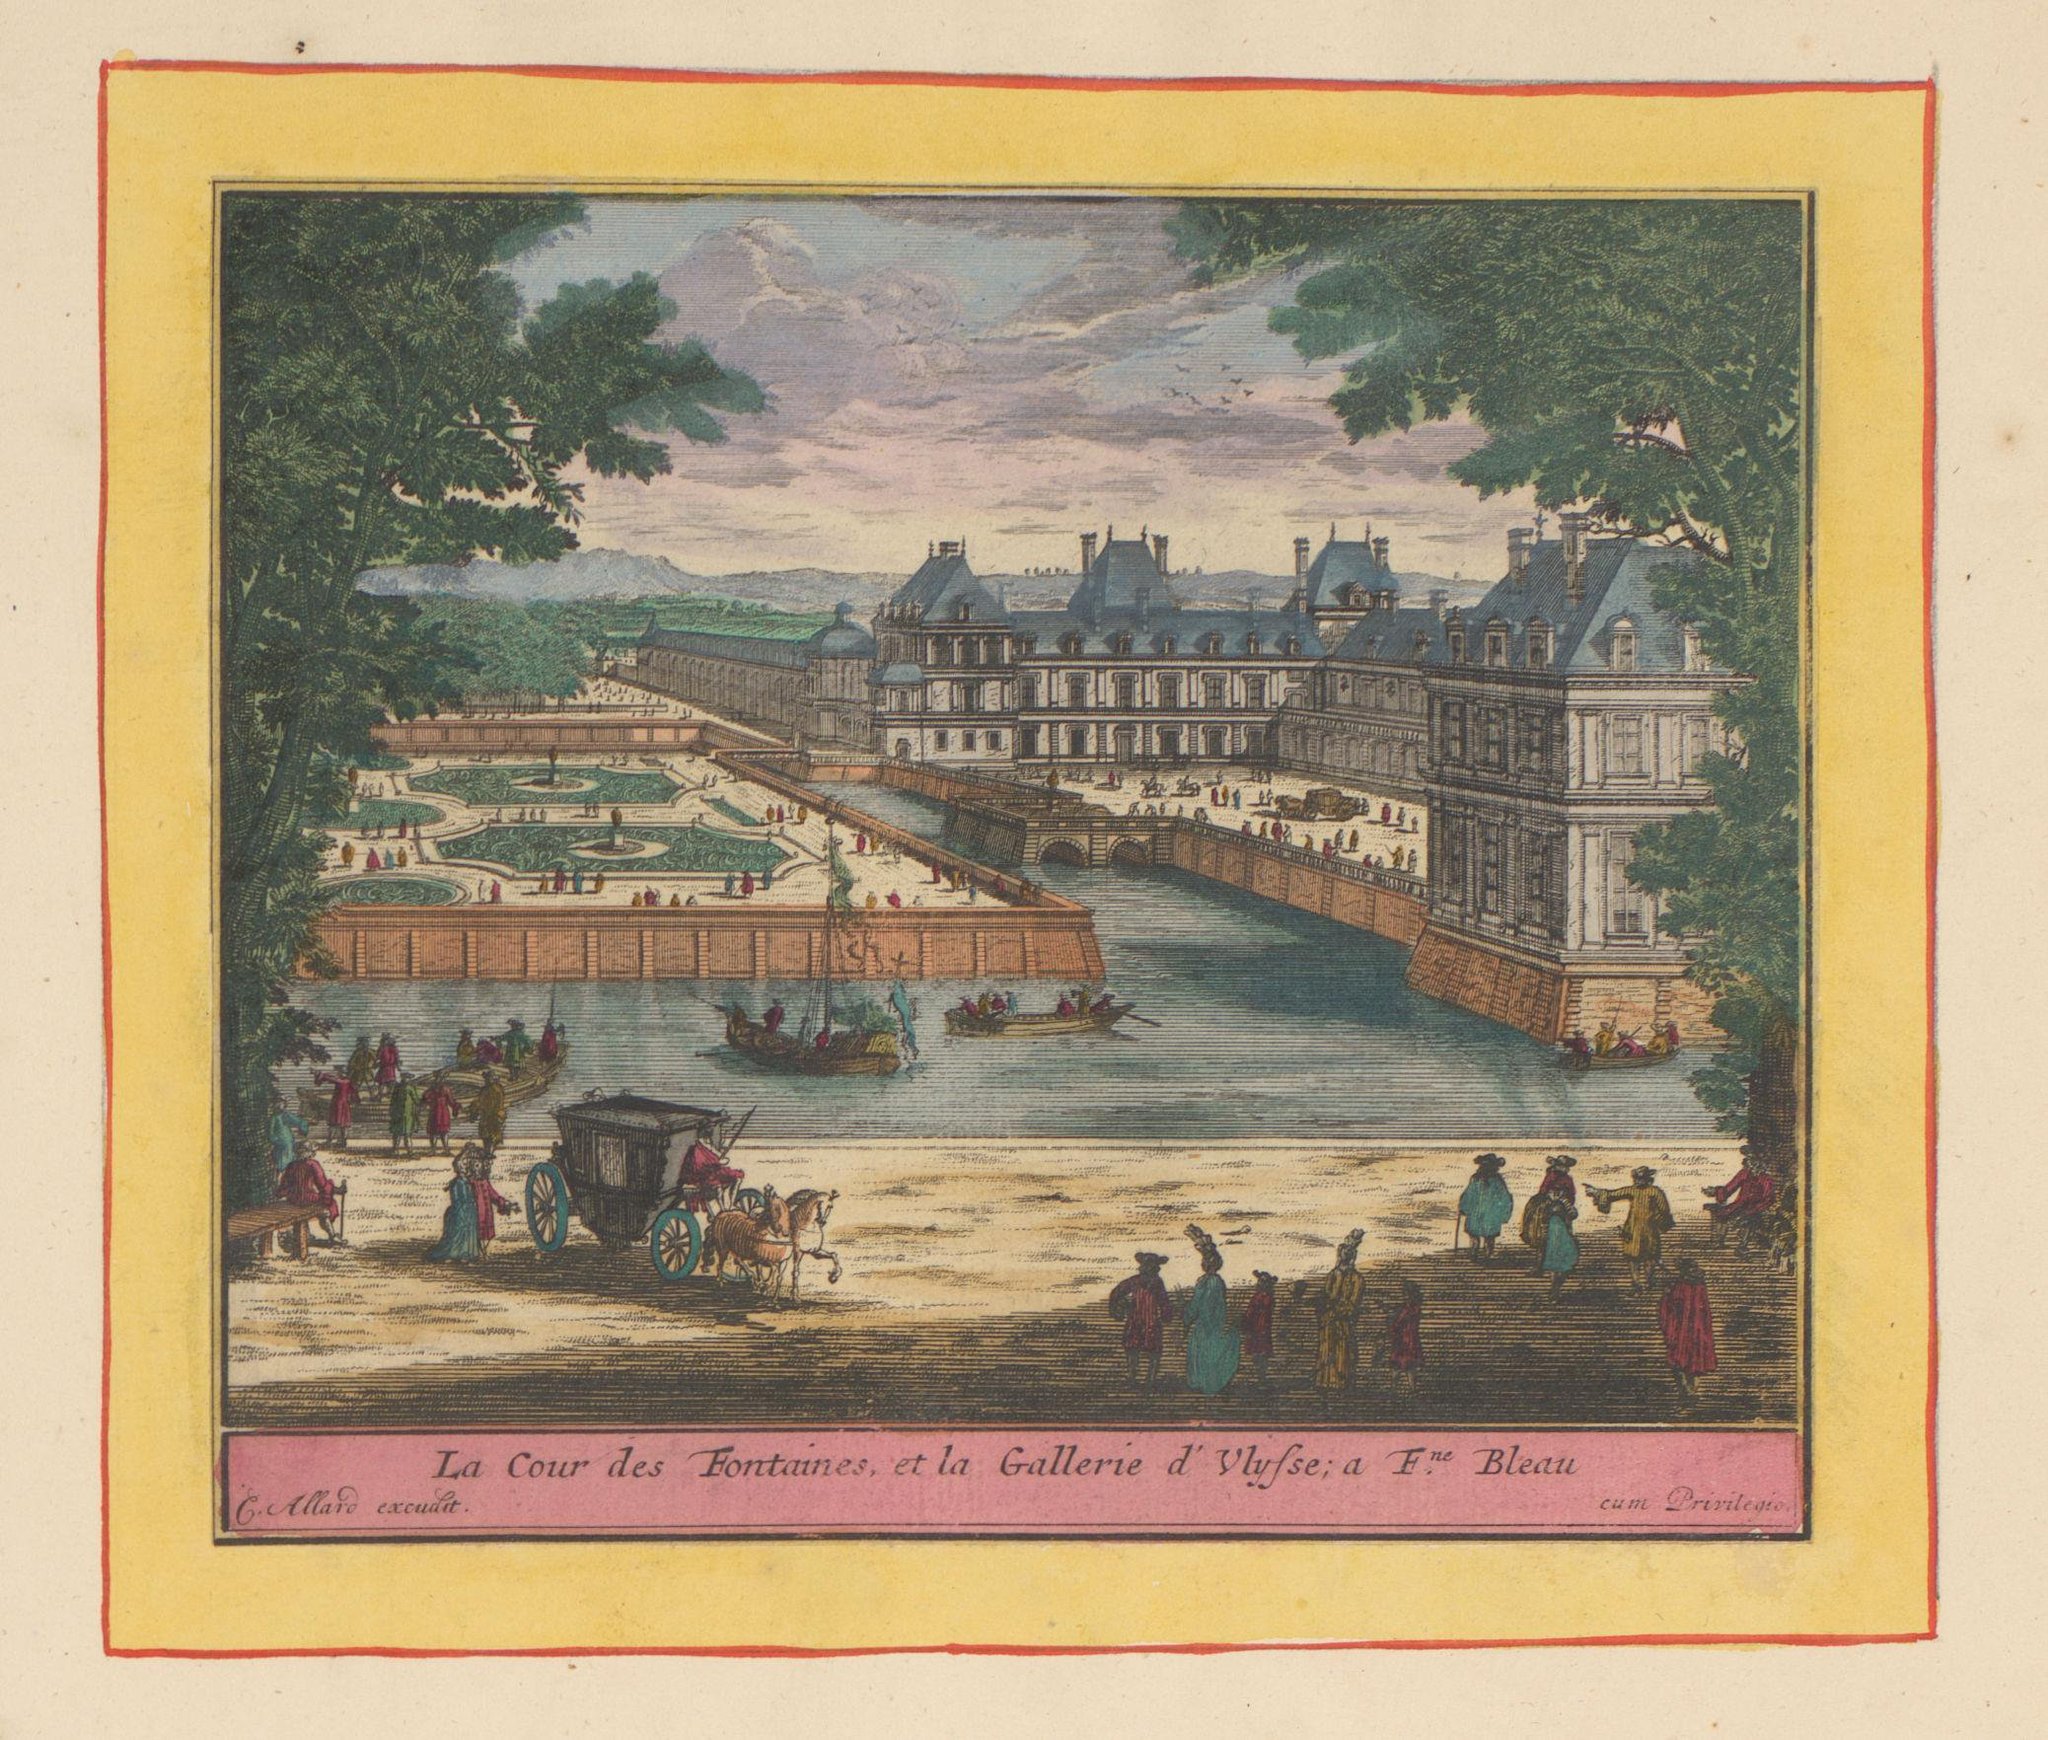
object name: album leaf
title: Gezicht op de Cour de la Fontaine en de galerie d'Ulysse van het paleis van Fontainebleau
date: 1684-1709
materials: paper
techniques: etching, hand coloring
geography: the hague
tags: palace, bird's eye view ~ representation of building, courtyard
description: De Cour de la Fontaine en de galerie d'Ulysse van het paleis van Fontainebleau, van rechts gezien. Op de voorgrond staan figuren en een koets voor de slotgracht die rondom het paleis loopt. Prent maakt deel uit van een album.